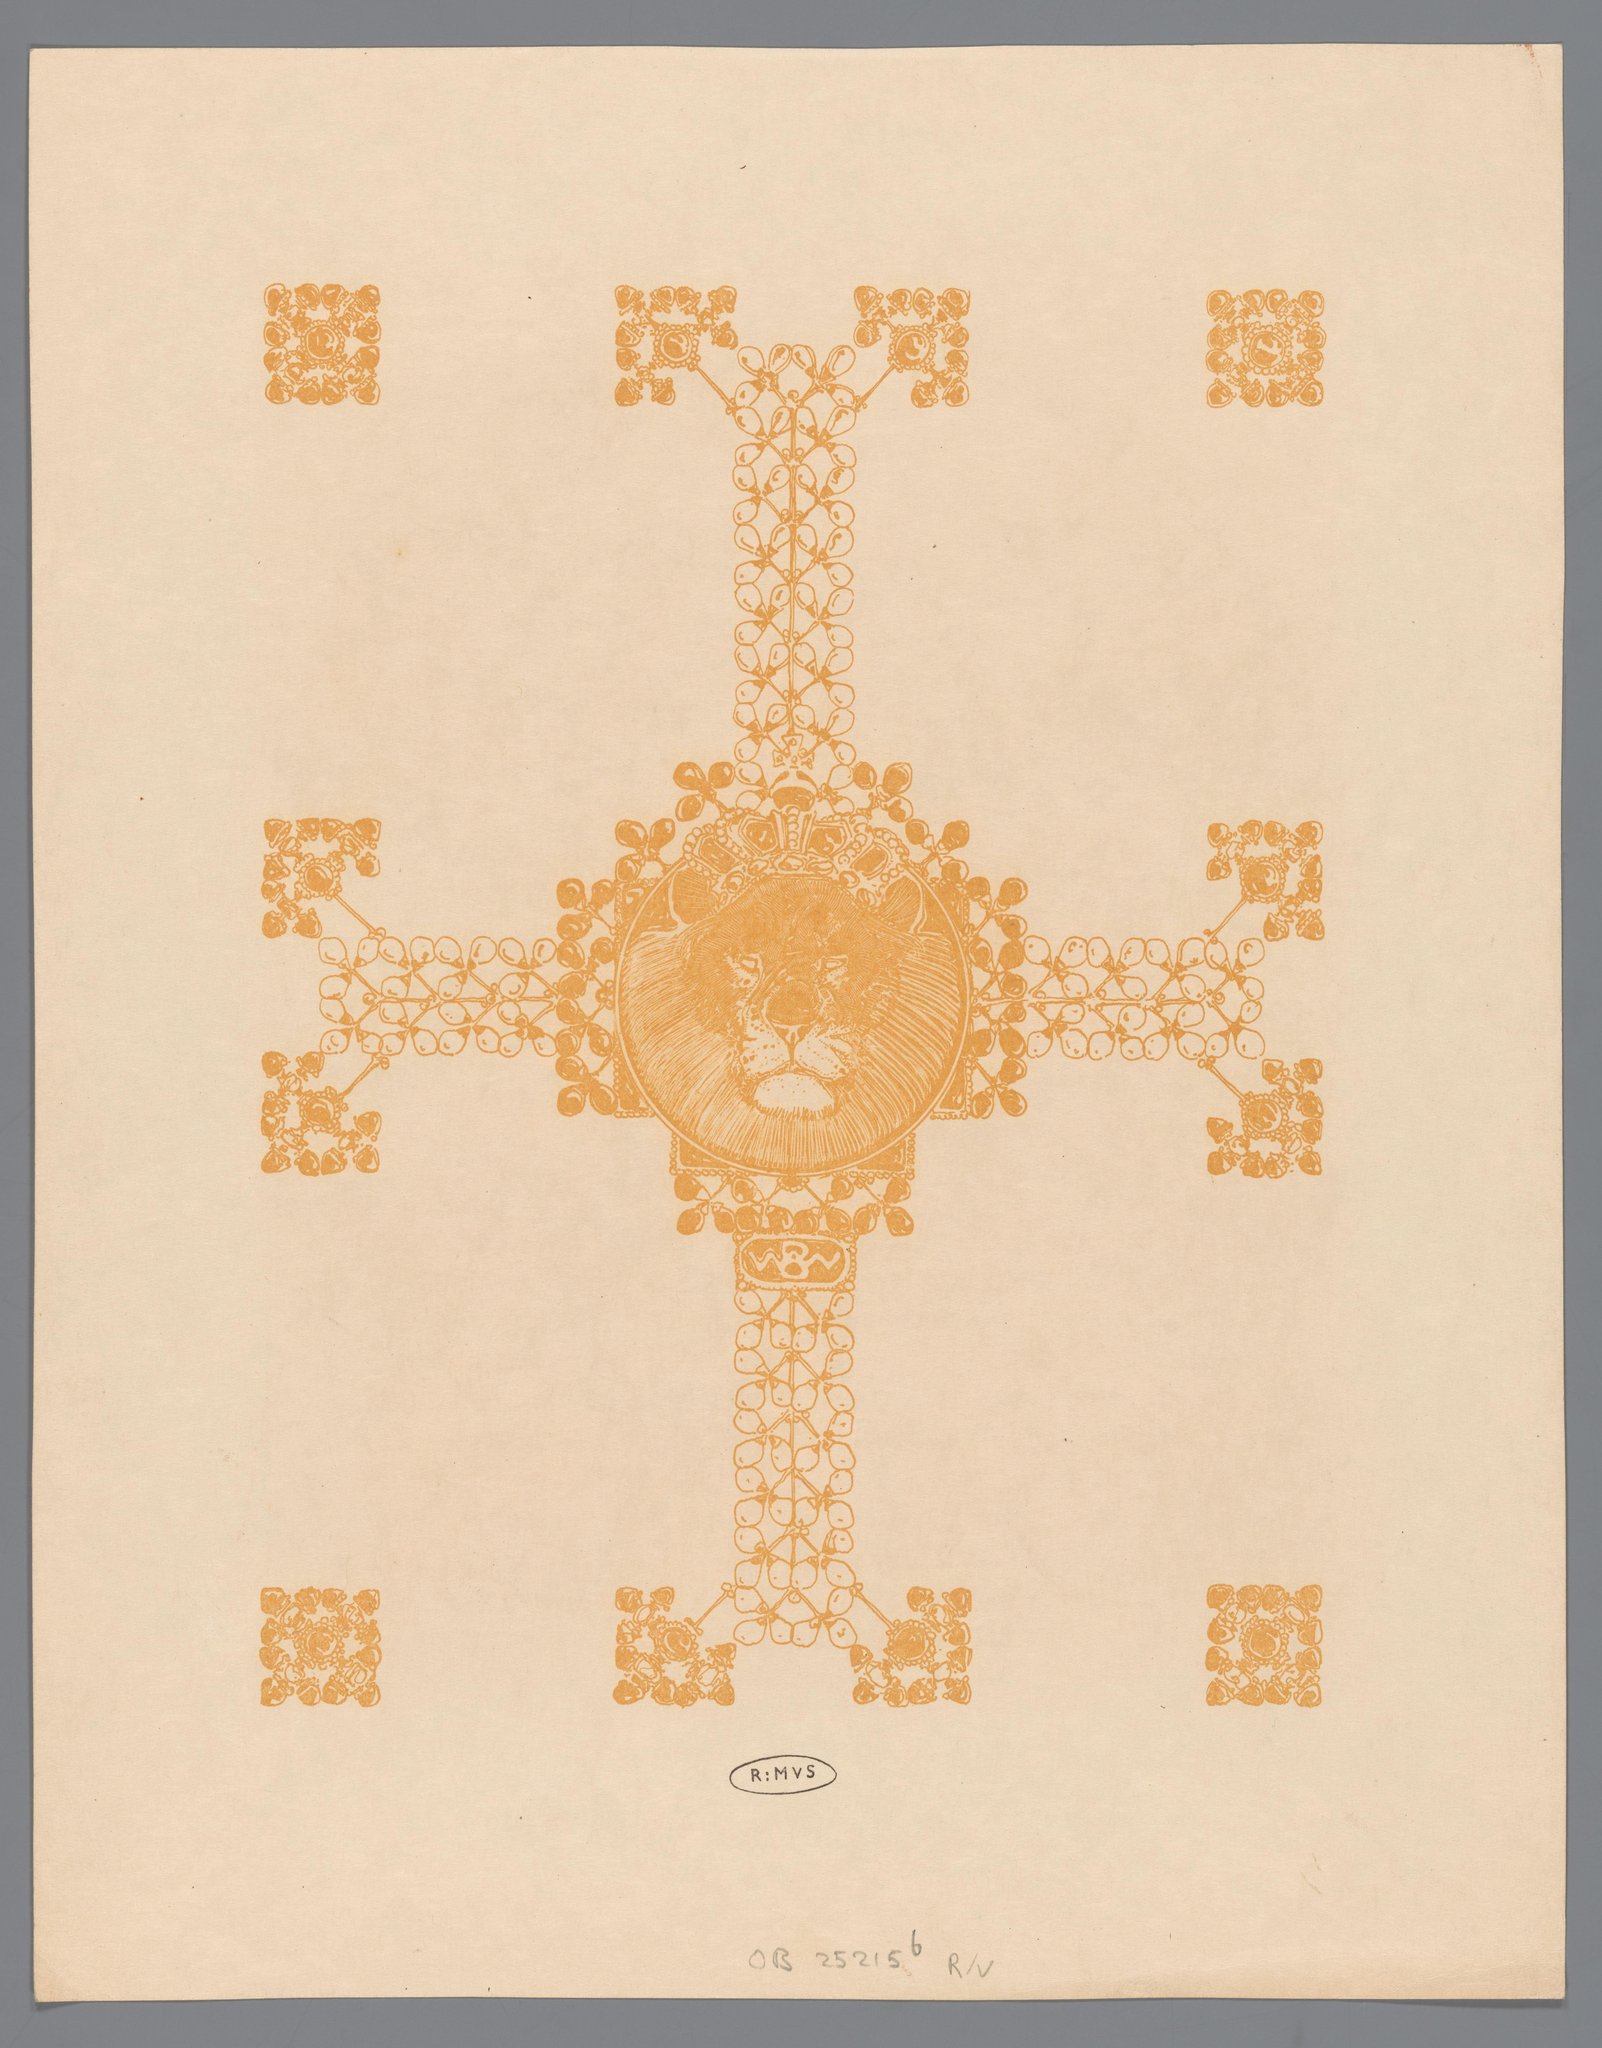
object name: print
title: Ornamentiek en gekroonde leeuw (Nobel)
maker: bernard willem wierink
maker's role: draughtsman, print maker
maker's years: 1856-1939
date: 1910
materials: paper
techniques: lithograph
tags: fable of reynard the fox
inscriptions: collector's mark: Lugt 2228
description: Prent gebruikt in: Streuvels, Stijn (Frank Lateur). Reinaert de Vos naar verschillende uitgaven van het middeleeuwsche epos. Amsterdam: L.J. Veen, 1910.